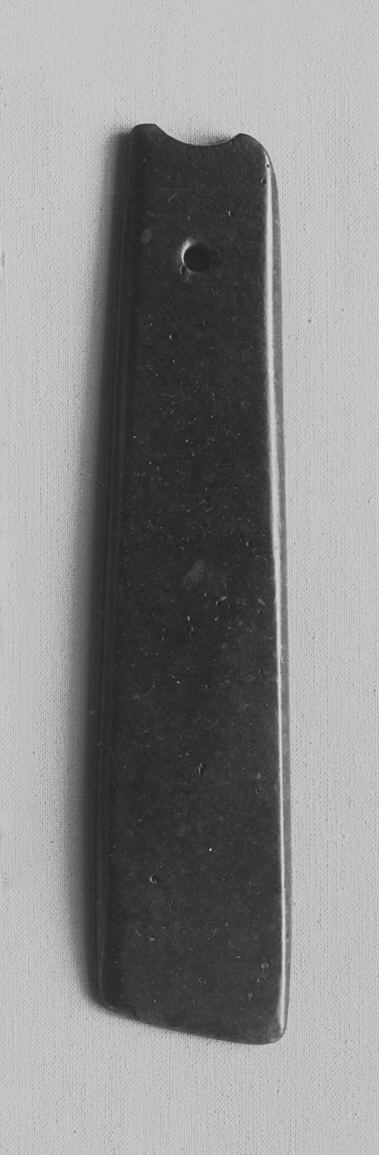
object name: knife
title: Blade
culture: chinese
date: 2200-1600 BCE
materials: jade